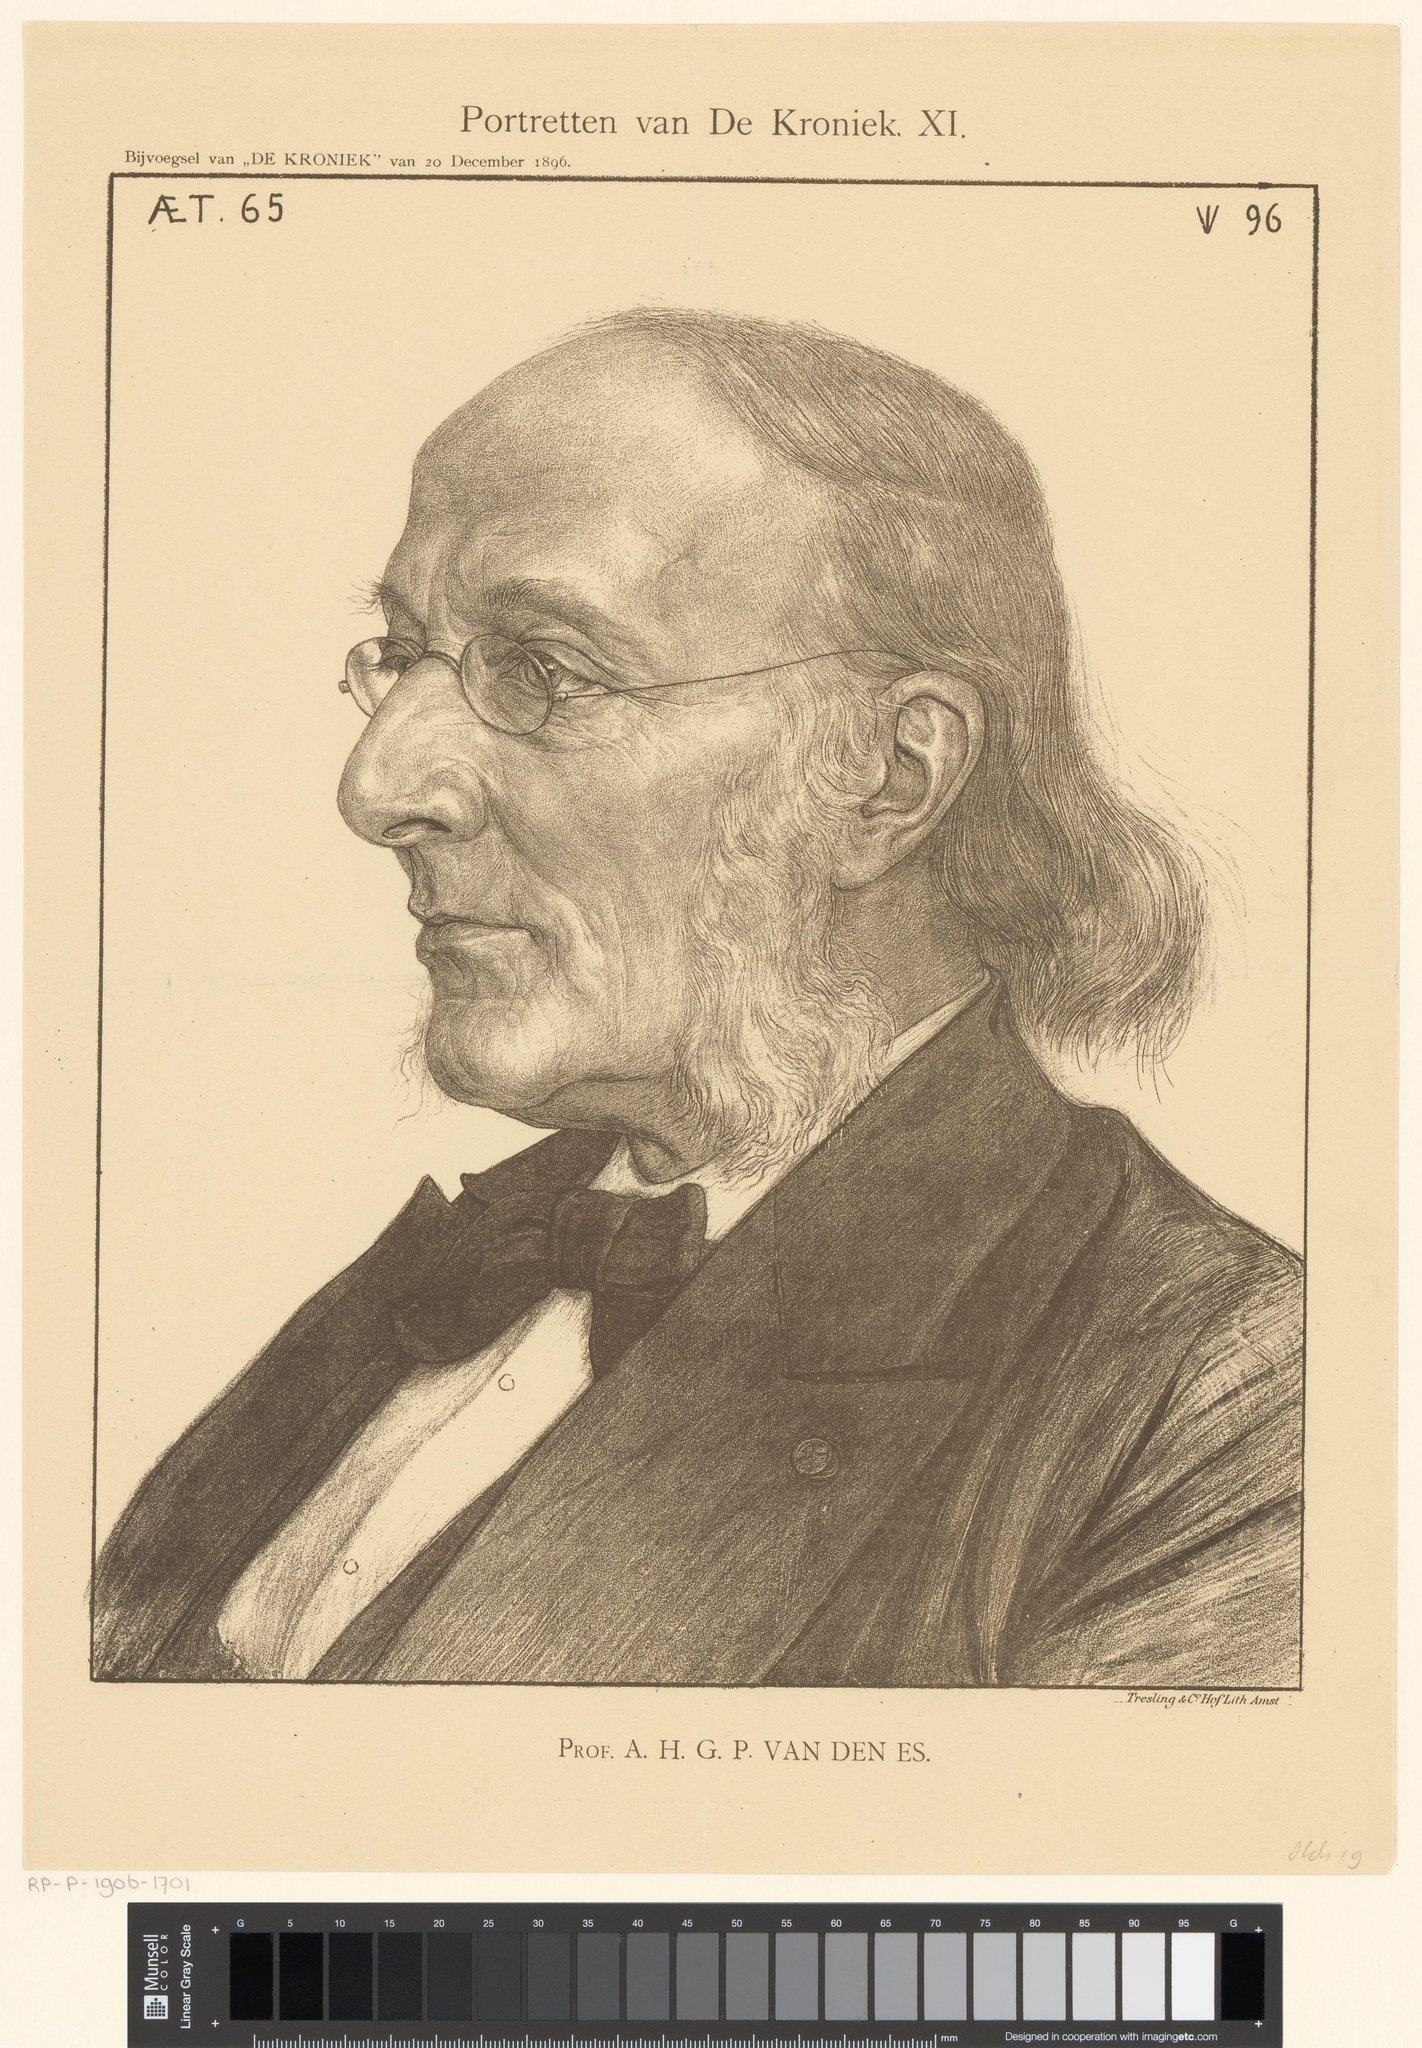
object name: print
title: Prof. A.H.G.P. van den Es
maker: jan veth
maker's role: designer, draughtsman, painter, print maker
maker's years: 1864-1925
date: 1896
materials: paper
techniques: lithograph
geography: amsterdam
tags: historical persons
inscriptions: collector's mark: Lugt 2228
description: Dit portret werd uitgegeven als bijvoegsel bij De Kroniek op 20 december 1896.